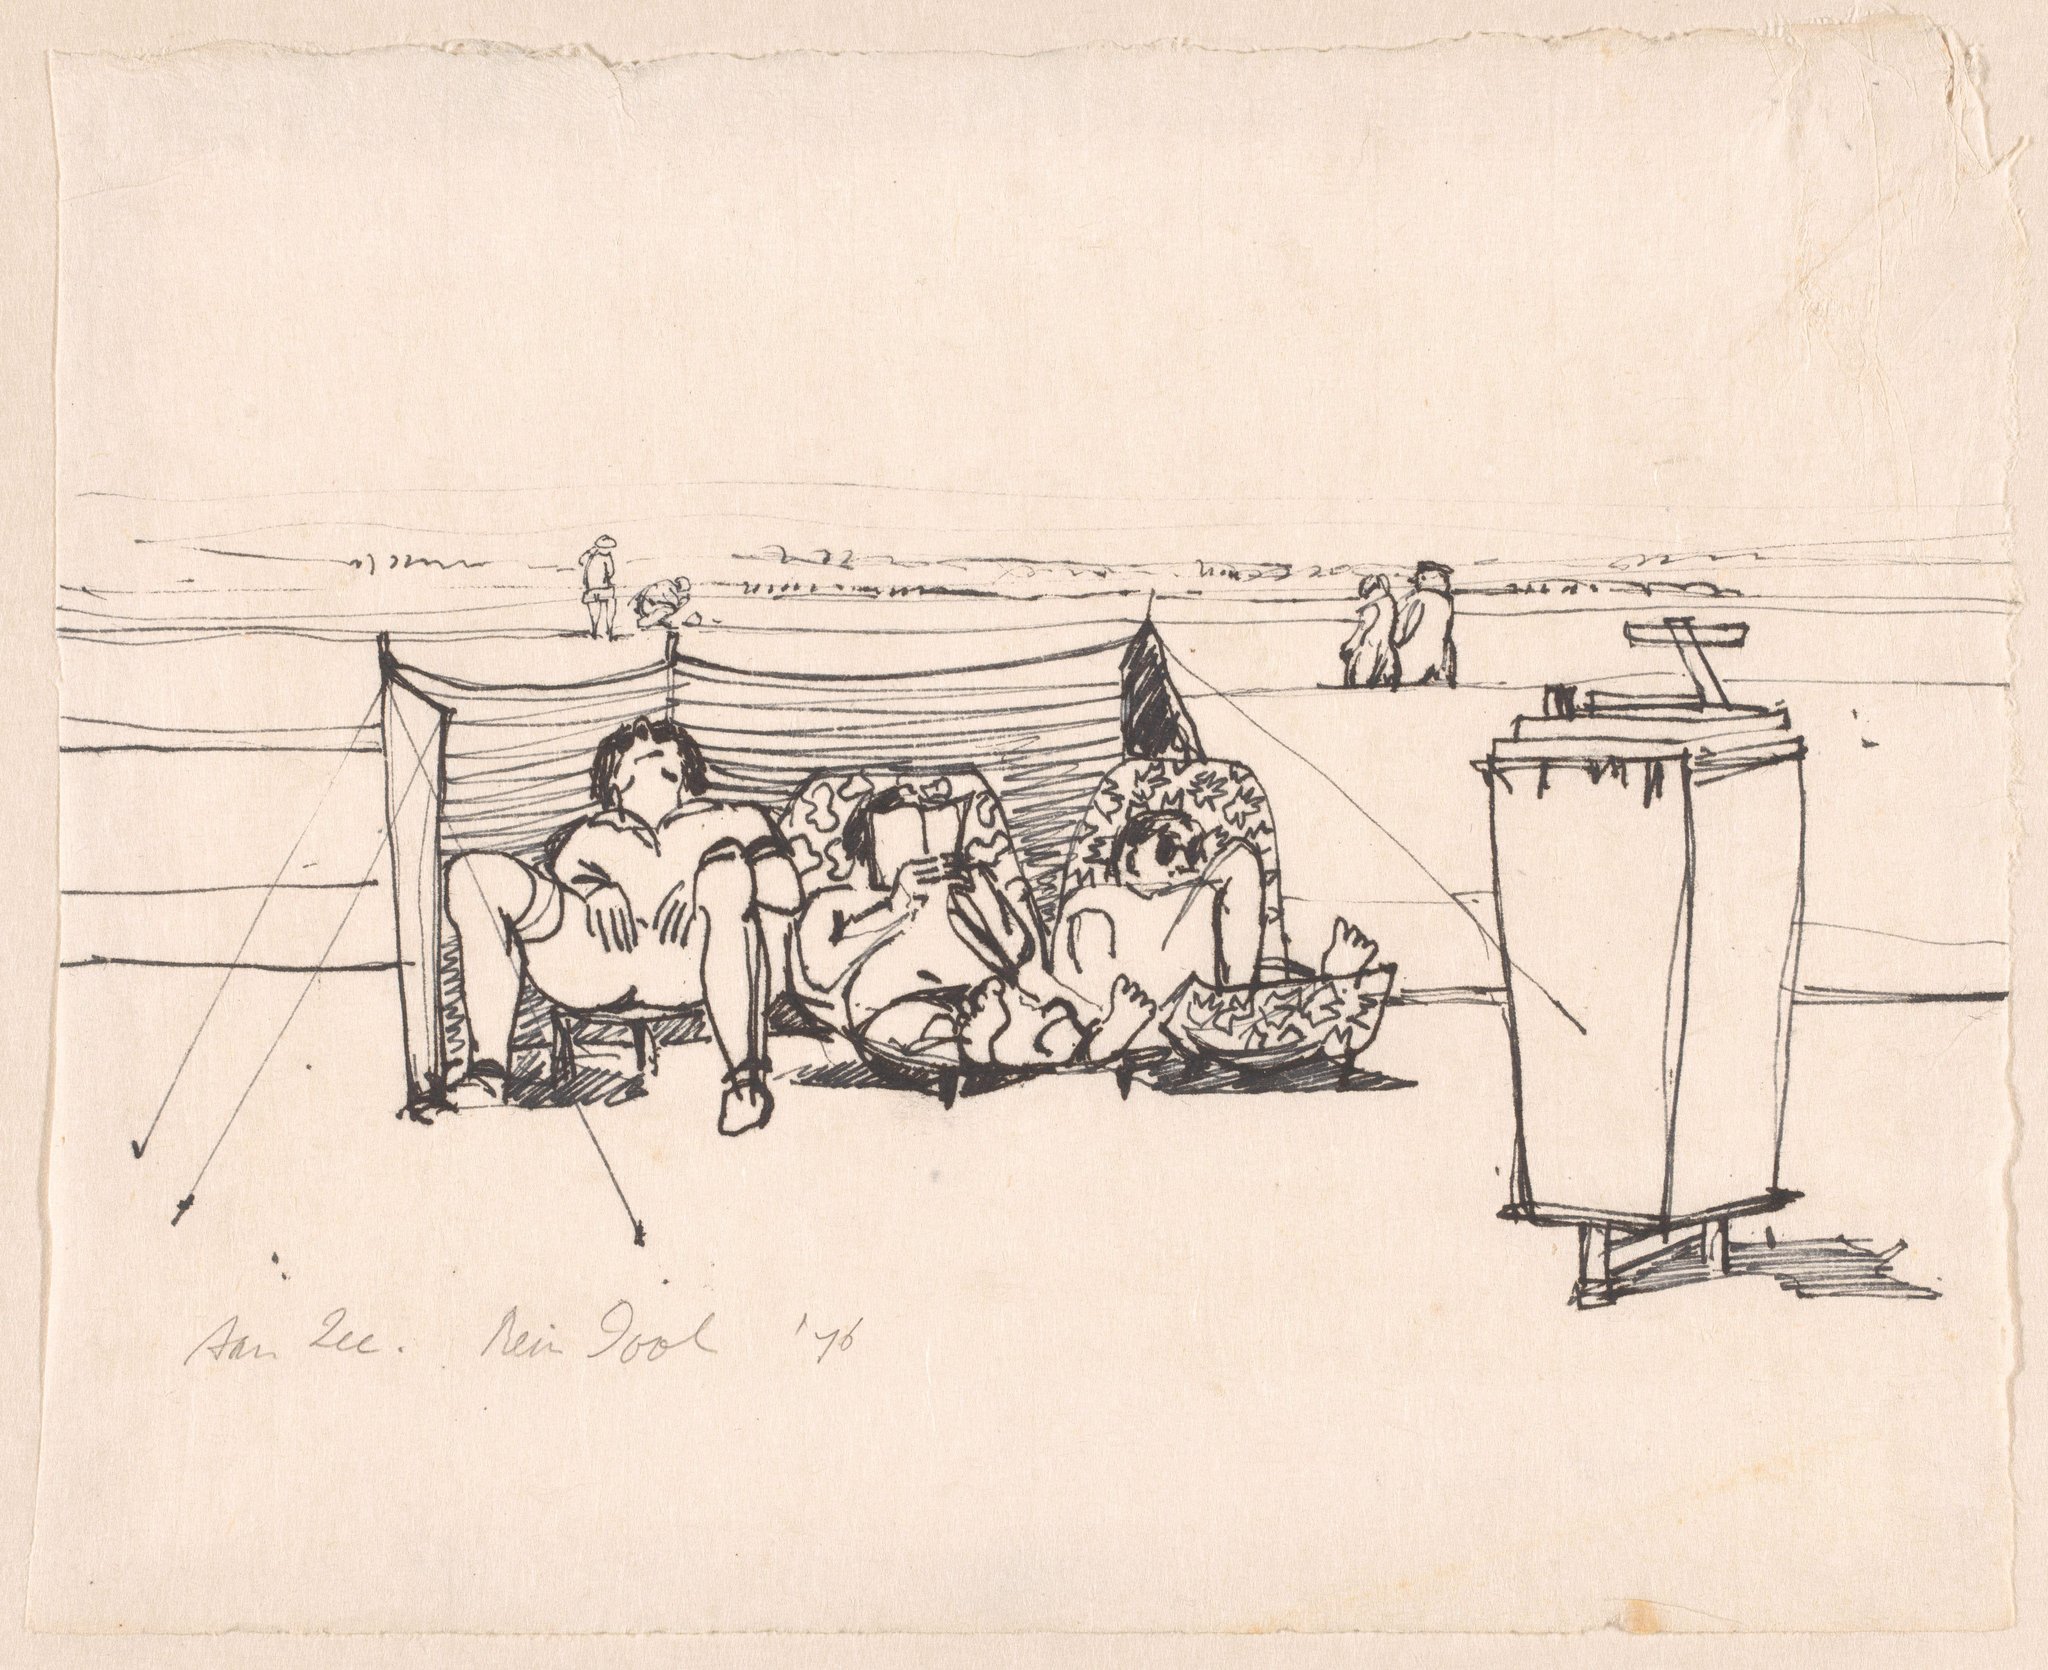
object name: drawing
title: Aan zee (Katwijk)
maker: rein dool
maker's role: draughtsman, painter, print maker, sculptor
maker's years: 1933-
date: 1976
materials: ink, paper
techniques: pen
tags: beach (as place of recreation), lying figure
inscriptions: signature and date